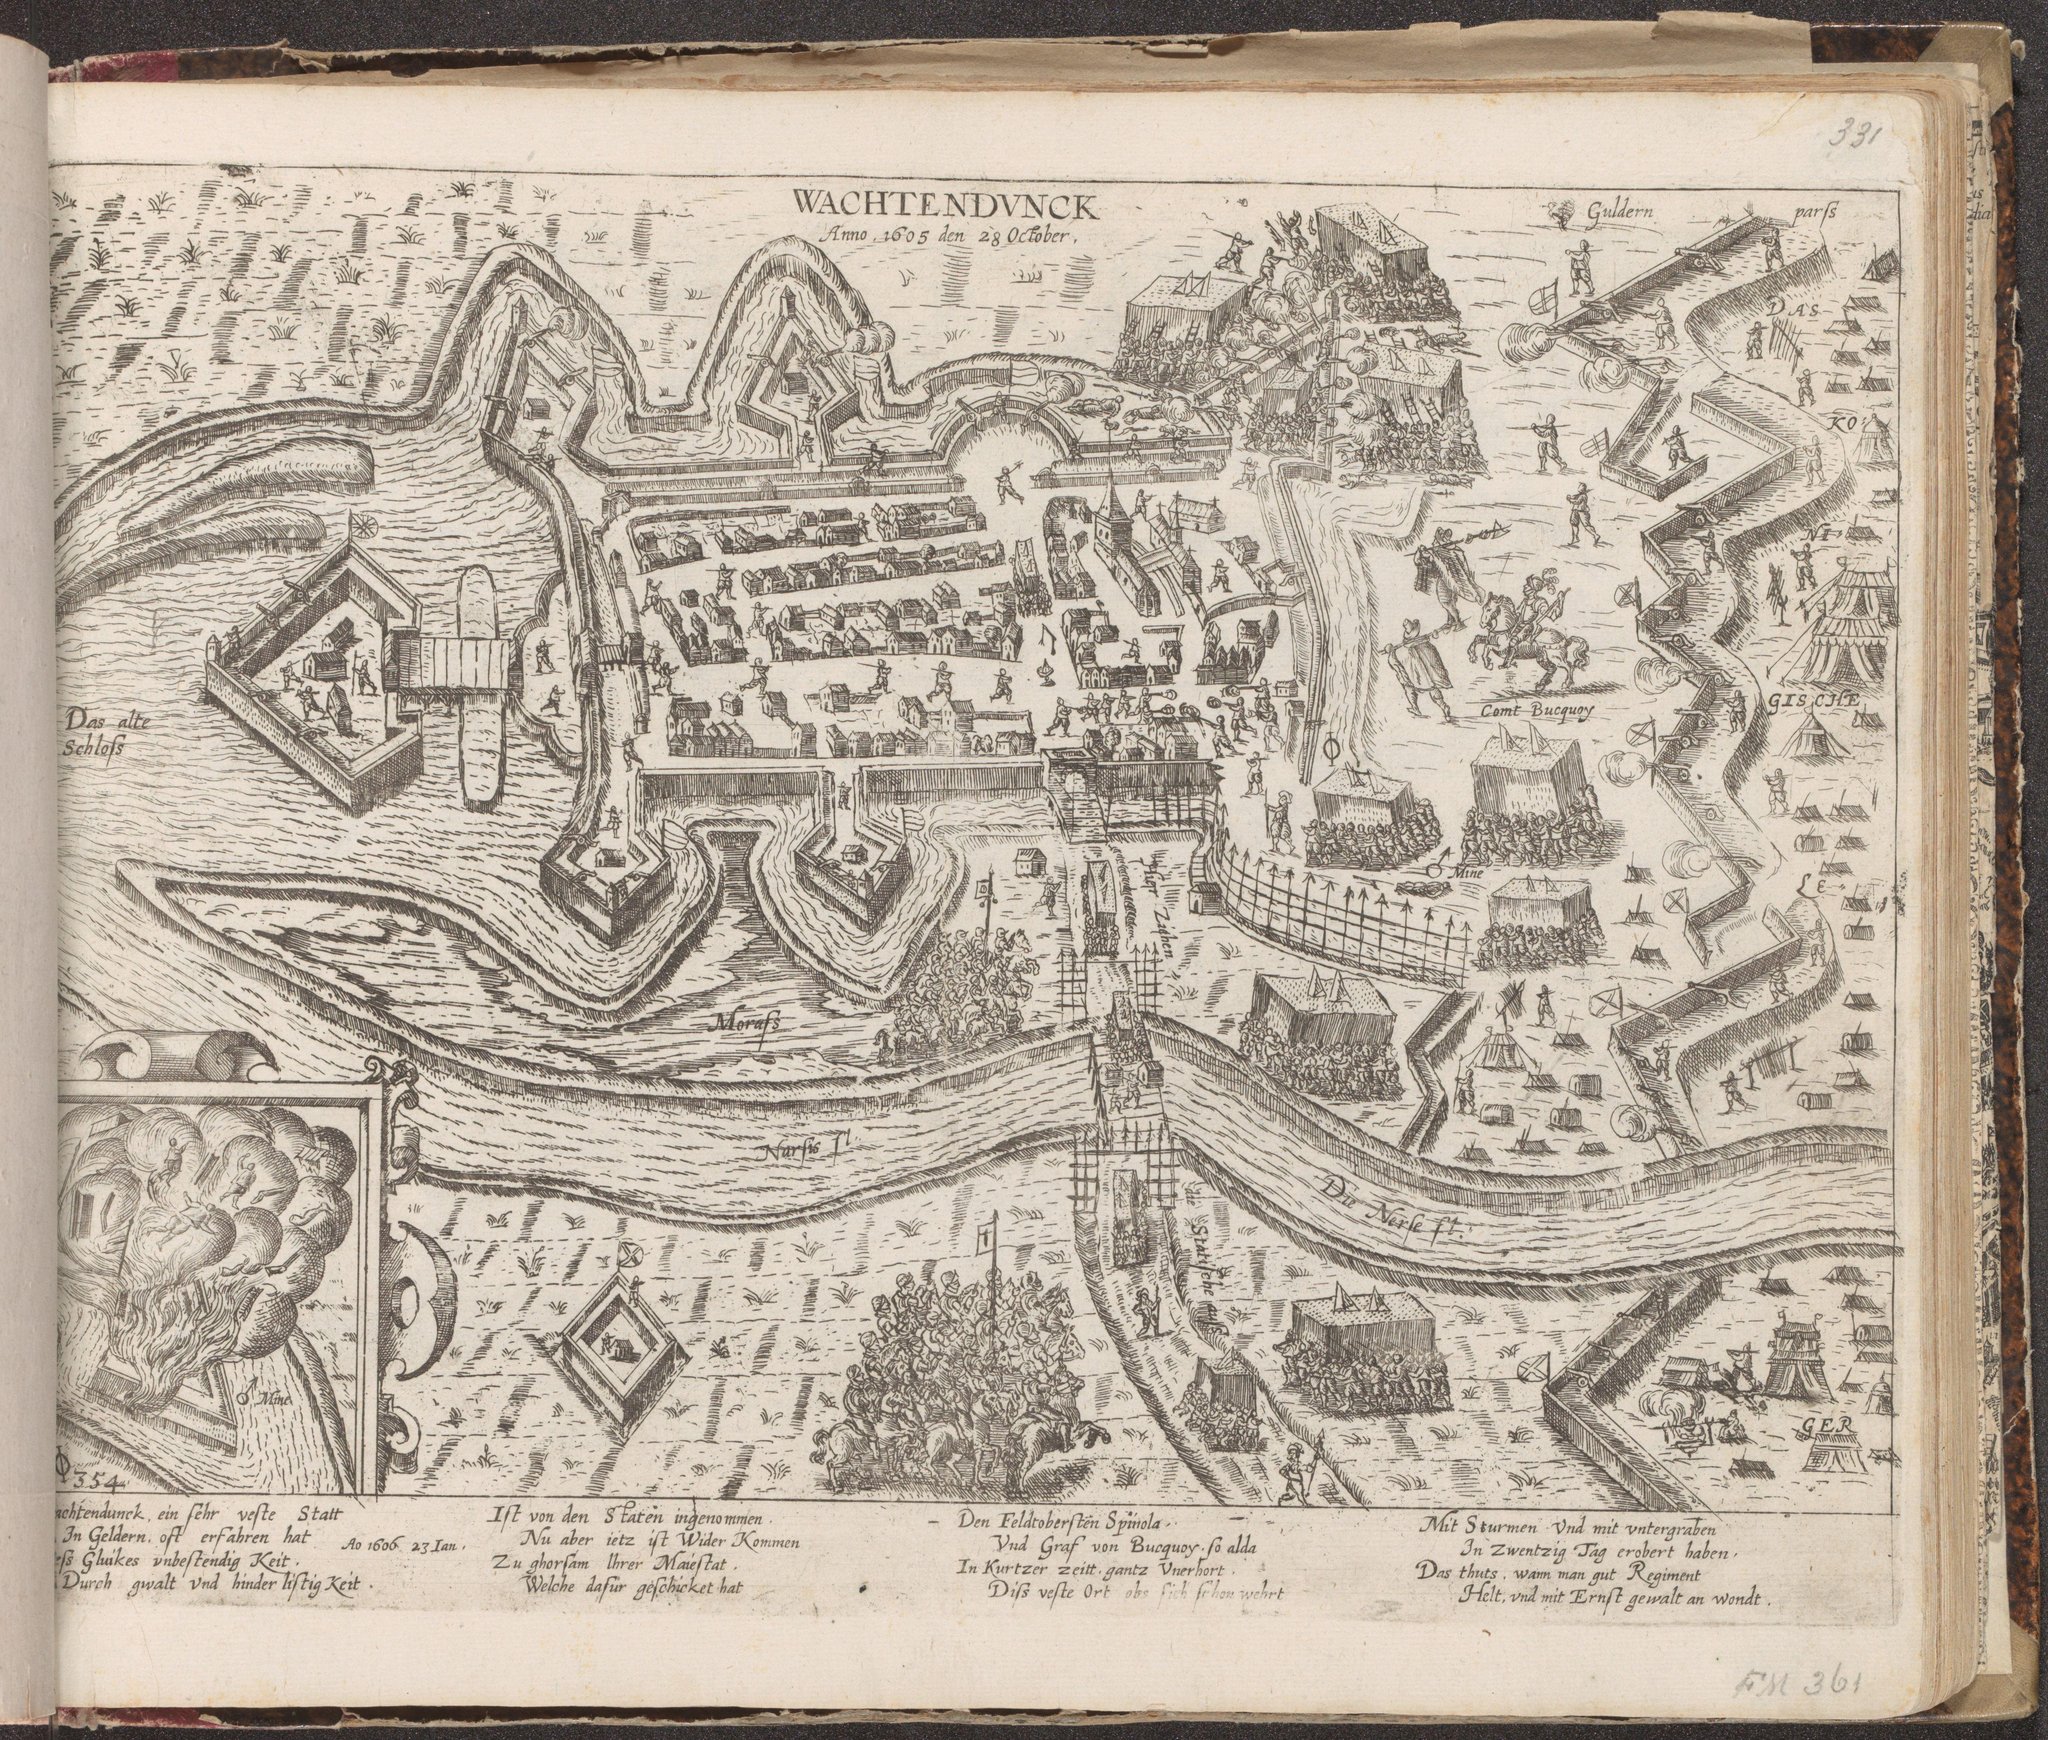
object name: album leaf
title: Serie 10: Nederlandse en Buitenlandse Gebeurtenissen, 1587-1612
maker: frans hogenberg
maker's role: print maker, publisher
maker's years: 1538-1590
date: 1605-1607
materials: paper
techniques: etching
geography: cologne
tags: capture of city (after the siege)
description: Beleg en verovering van Wachtendock door de graaf van Bucquoy, 28 oktober 1605. Plan van de stad, rechts het legerkamp van het Spaanse leger. Linksonder een inzet met de ontploffende ondermijnde stadsmuur. Onderaan verlaat het Staatse leger de stad. Met onderschrift van 16 regels in het Duits. Linksonder genummerd: 354. De prent maakt deel uit van een album.